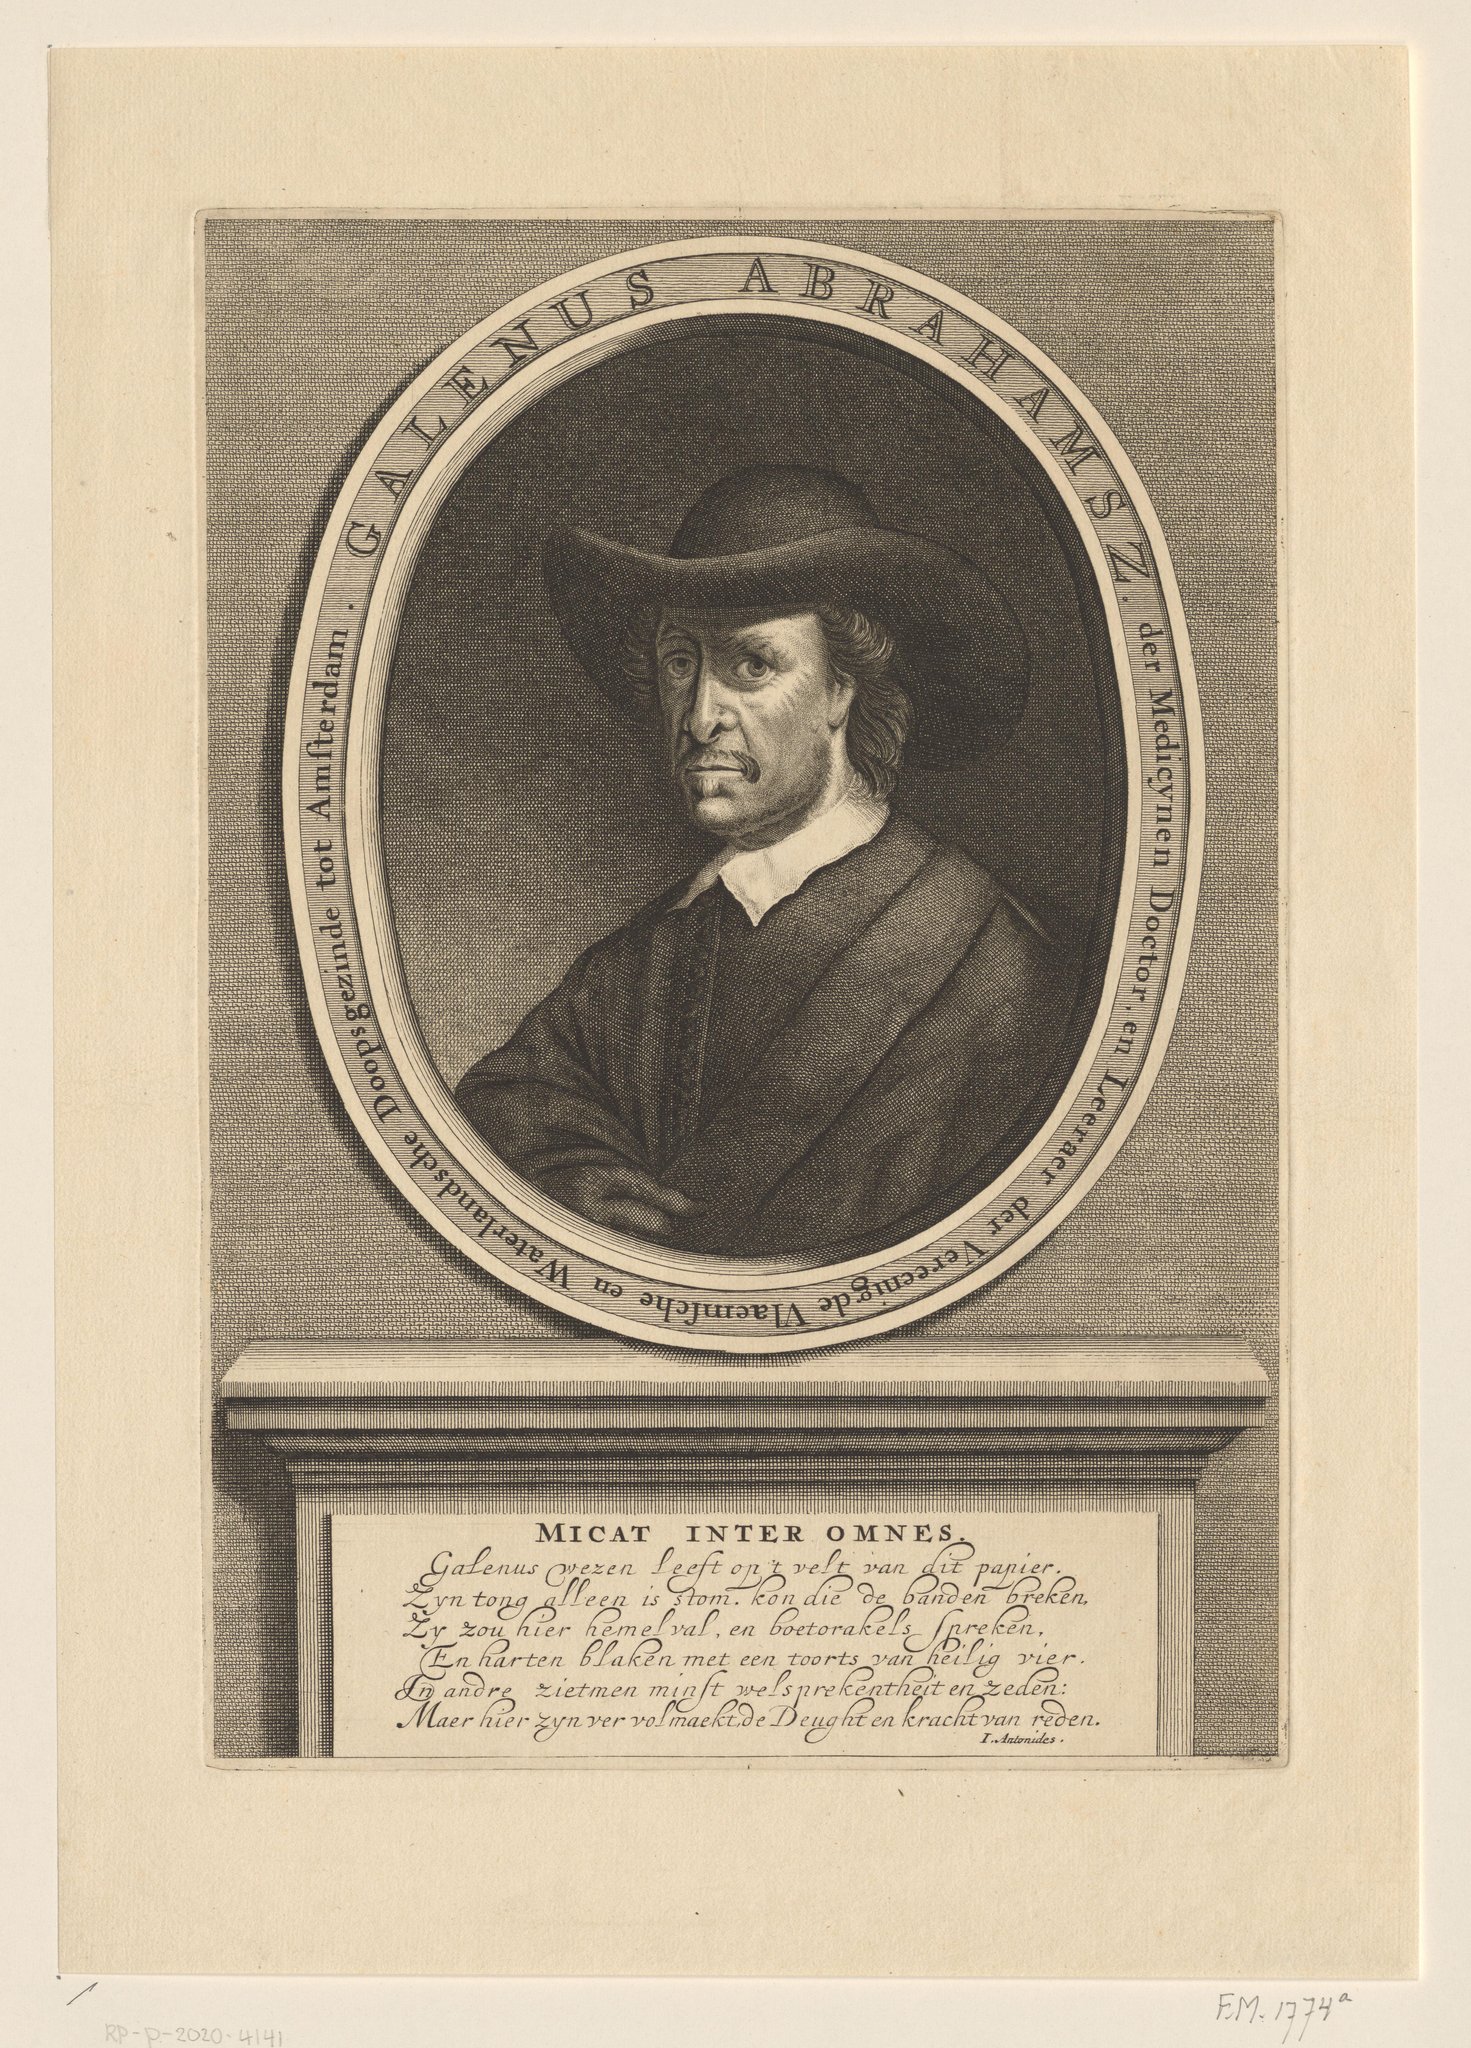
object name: print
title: Portret van Galenus Abrahamsz. de Haan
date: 1685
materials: paper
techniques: engraving, etching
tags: amsterdam, galenus abrahamsz. de haan, historical persons, physician, doctor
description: Het gedicht onder het portret van Joannes Antonides van der Goes, werd in 1685 (inclusief de tekst rond het ovaal) gepubliceerd onder de kop 'Op de afbeelding van den Hooggeleerden Godvruchtigen Galenus Abrahamsz' in: Gedichten van J. Antonides vander Goes, Amsterdam 1685, tweede deel, p. 274.